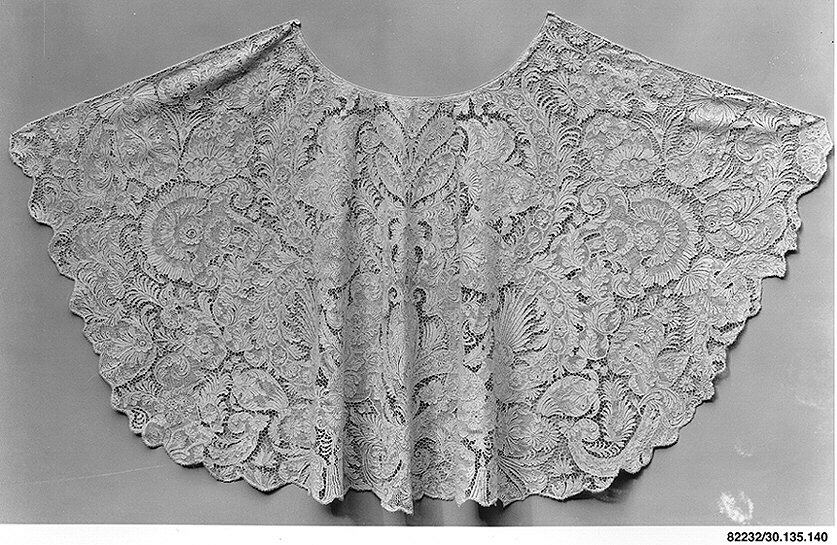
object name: collar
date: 1701-1800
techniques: lace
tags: flowers